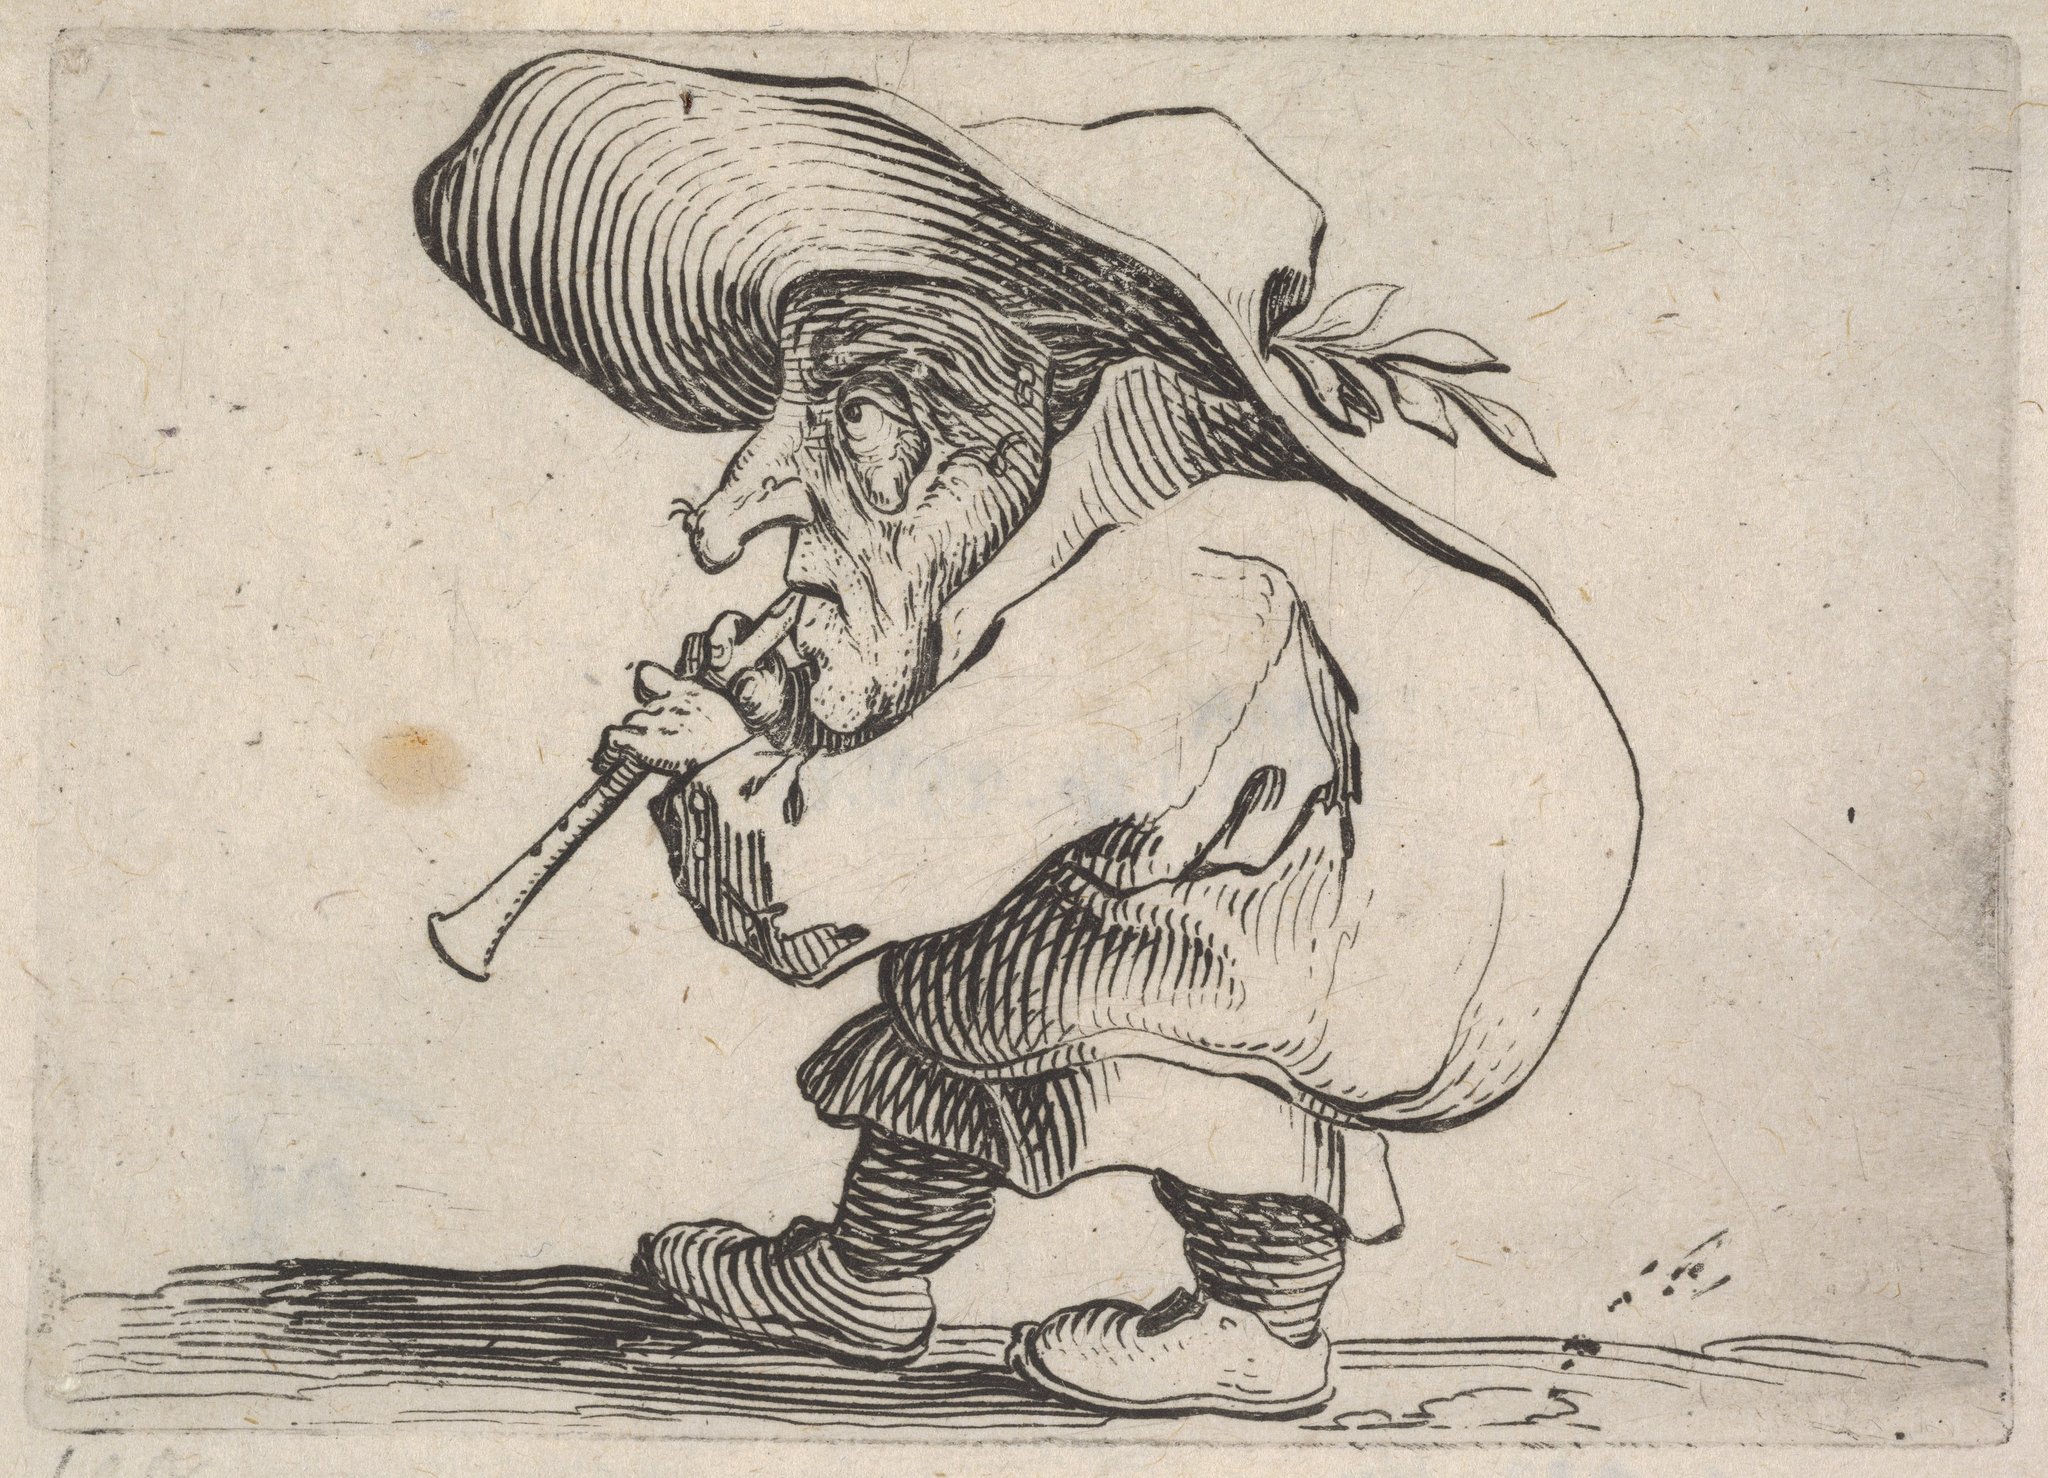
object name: print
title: Small male figure playing a wind instrument, in profile view, from "Varie Figure Gobbi"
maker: jacques callot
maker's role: artist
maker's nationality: french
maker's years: 1592-1635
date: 1621-1625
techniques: etching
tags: musical instruments,men,profiles